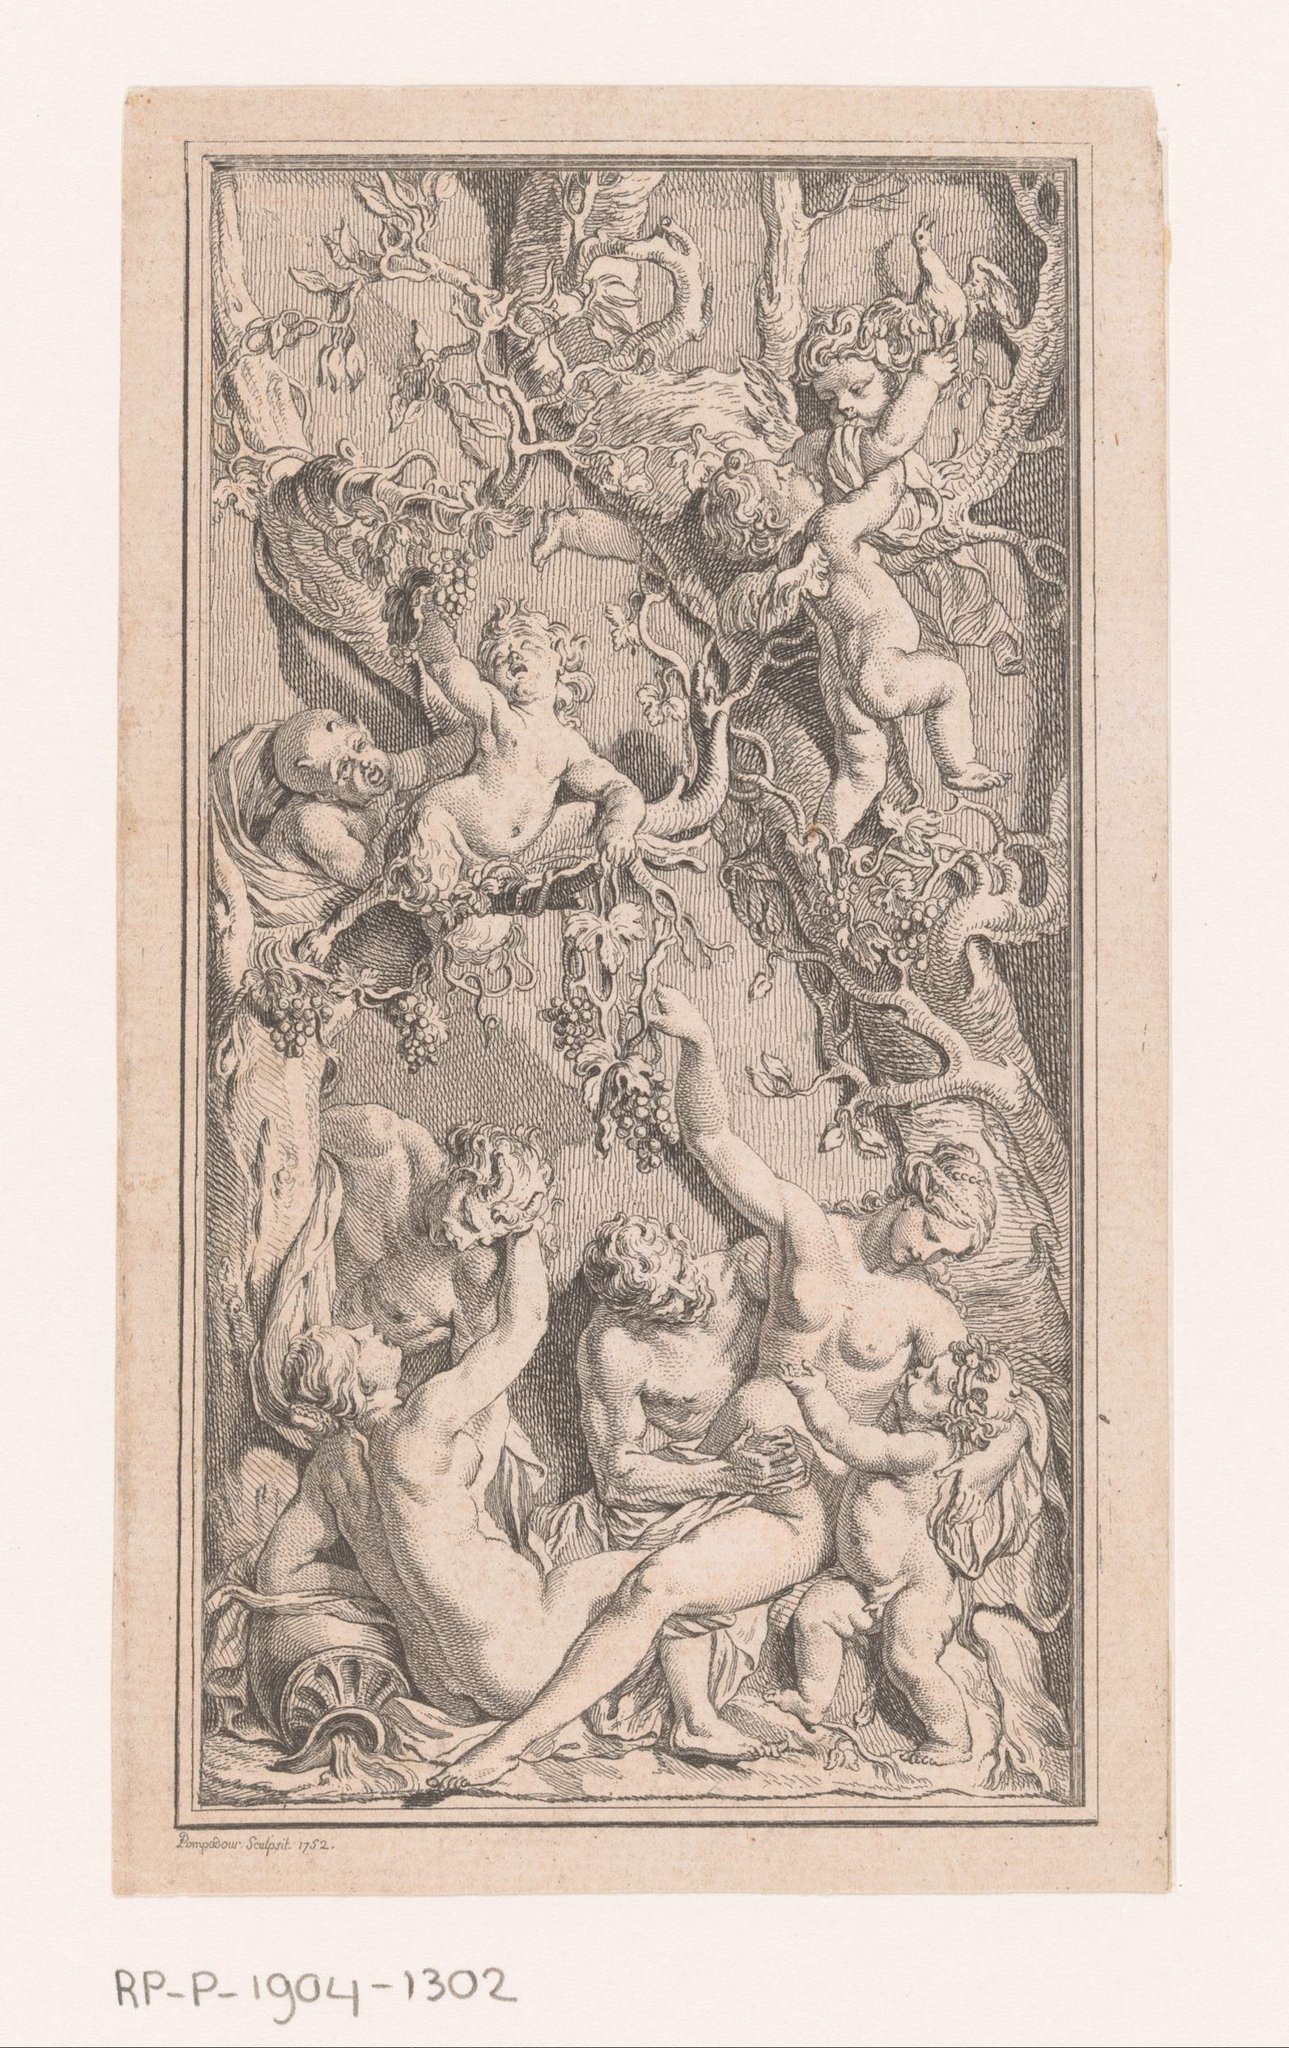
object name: print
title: Nimfen, saters en putti bij een boom met druivenranken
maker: madame de pompadour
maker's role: print maker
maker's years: 1721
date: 1752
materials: paper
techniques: etching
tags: nymphs (in general); 'ninfe in commune' (ripa), satyr(s) (in general), cupids: 'amores', 'amoretti', 'putti', autumn, fall, 'autumnus'; 'autunno' (ripa)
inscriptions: collector's mark: Lugt 2228